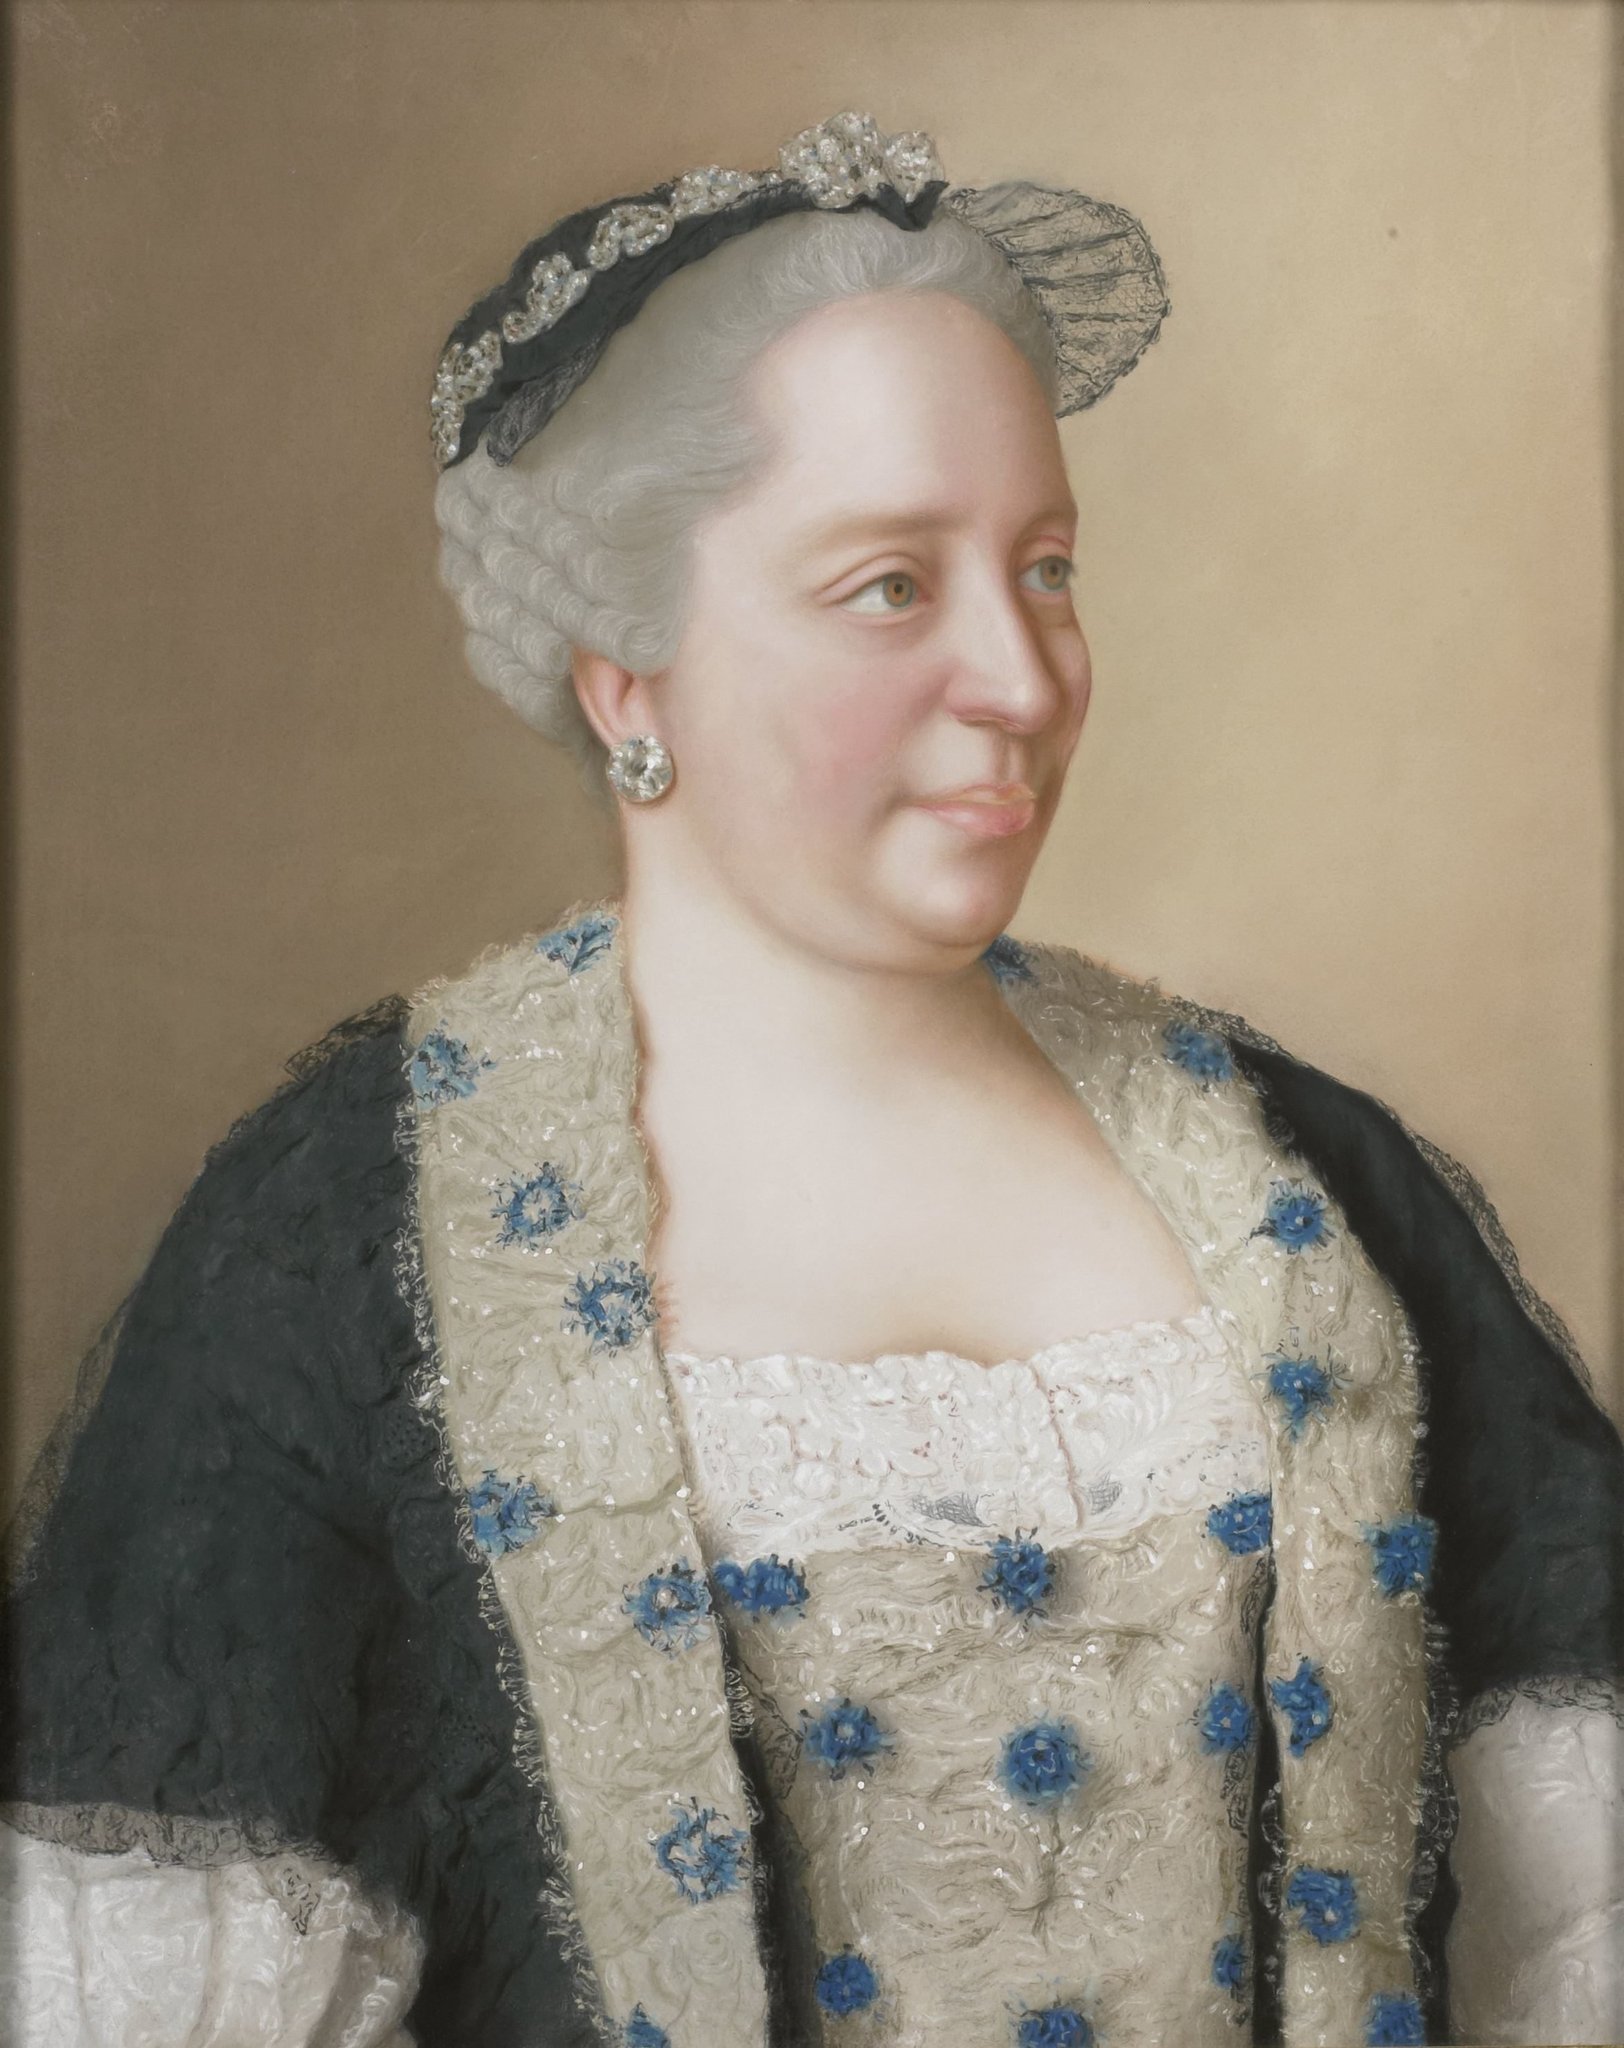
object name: drawing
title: Maria Theresia van Oostenrijk (1717-80), aartshertogin van Oostenrijk, koningin van Hongarije en Bohemen, Rooms-Duits keizerin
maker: jean-etienne liotard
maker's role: painter, print maker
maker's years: 1702-1789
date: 1762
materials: parchment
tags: vienna, maria theresia (rooms-duits keizerin), historical persons - bb - woman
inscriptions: inscription: ‘Marie Therese d'Autriche, Impératrice reine d'Hongrie & de Bohème, peinte d'après nature par Liotard’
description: Jean-Etienne Liotard (1702 - 1789). Maria Theresia (1717 - 80), Empress of Austria, Queen of Hungary and Bohemia. Miss M.A. Liotard bequest, Amsterdam, 1873.